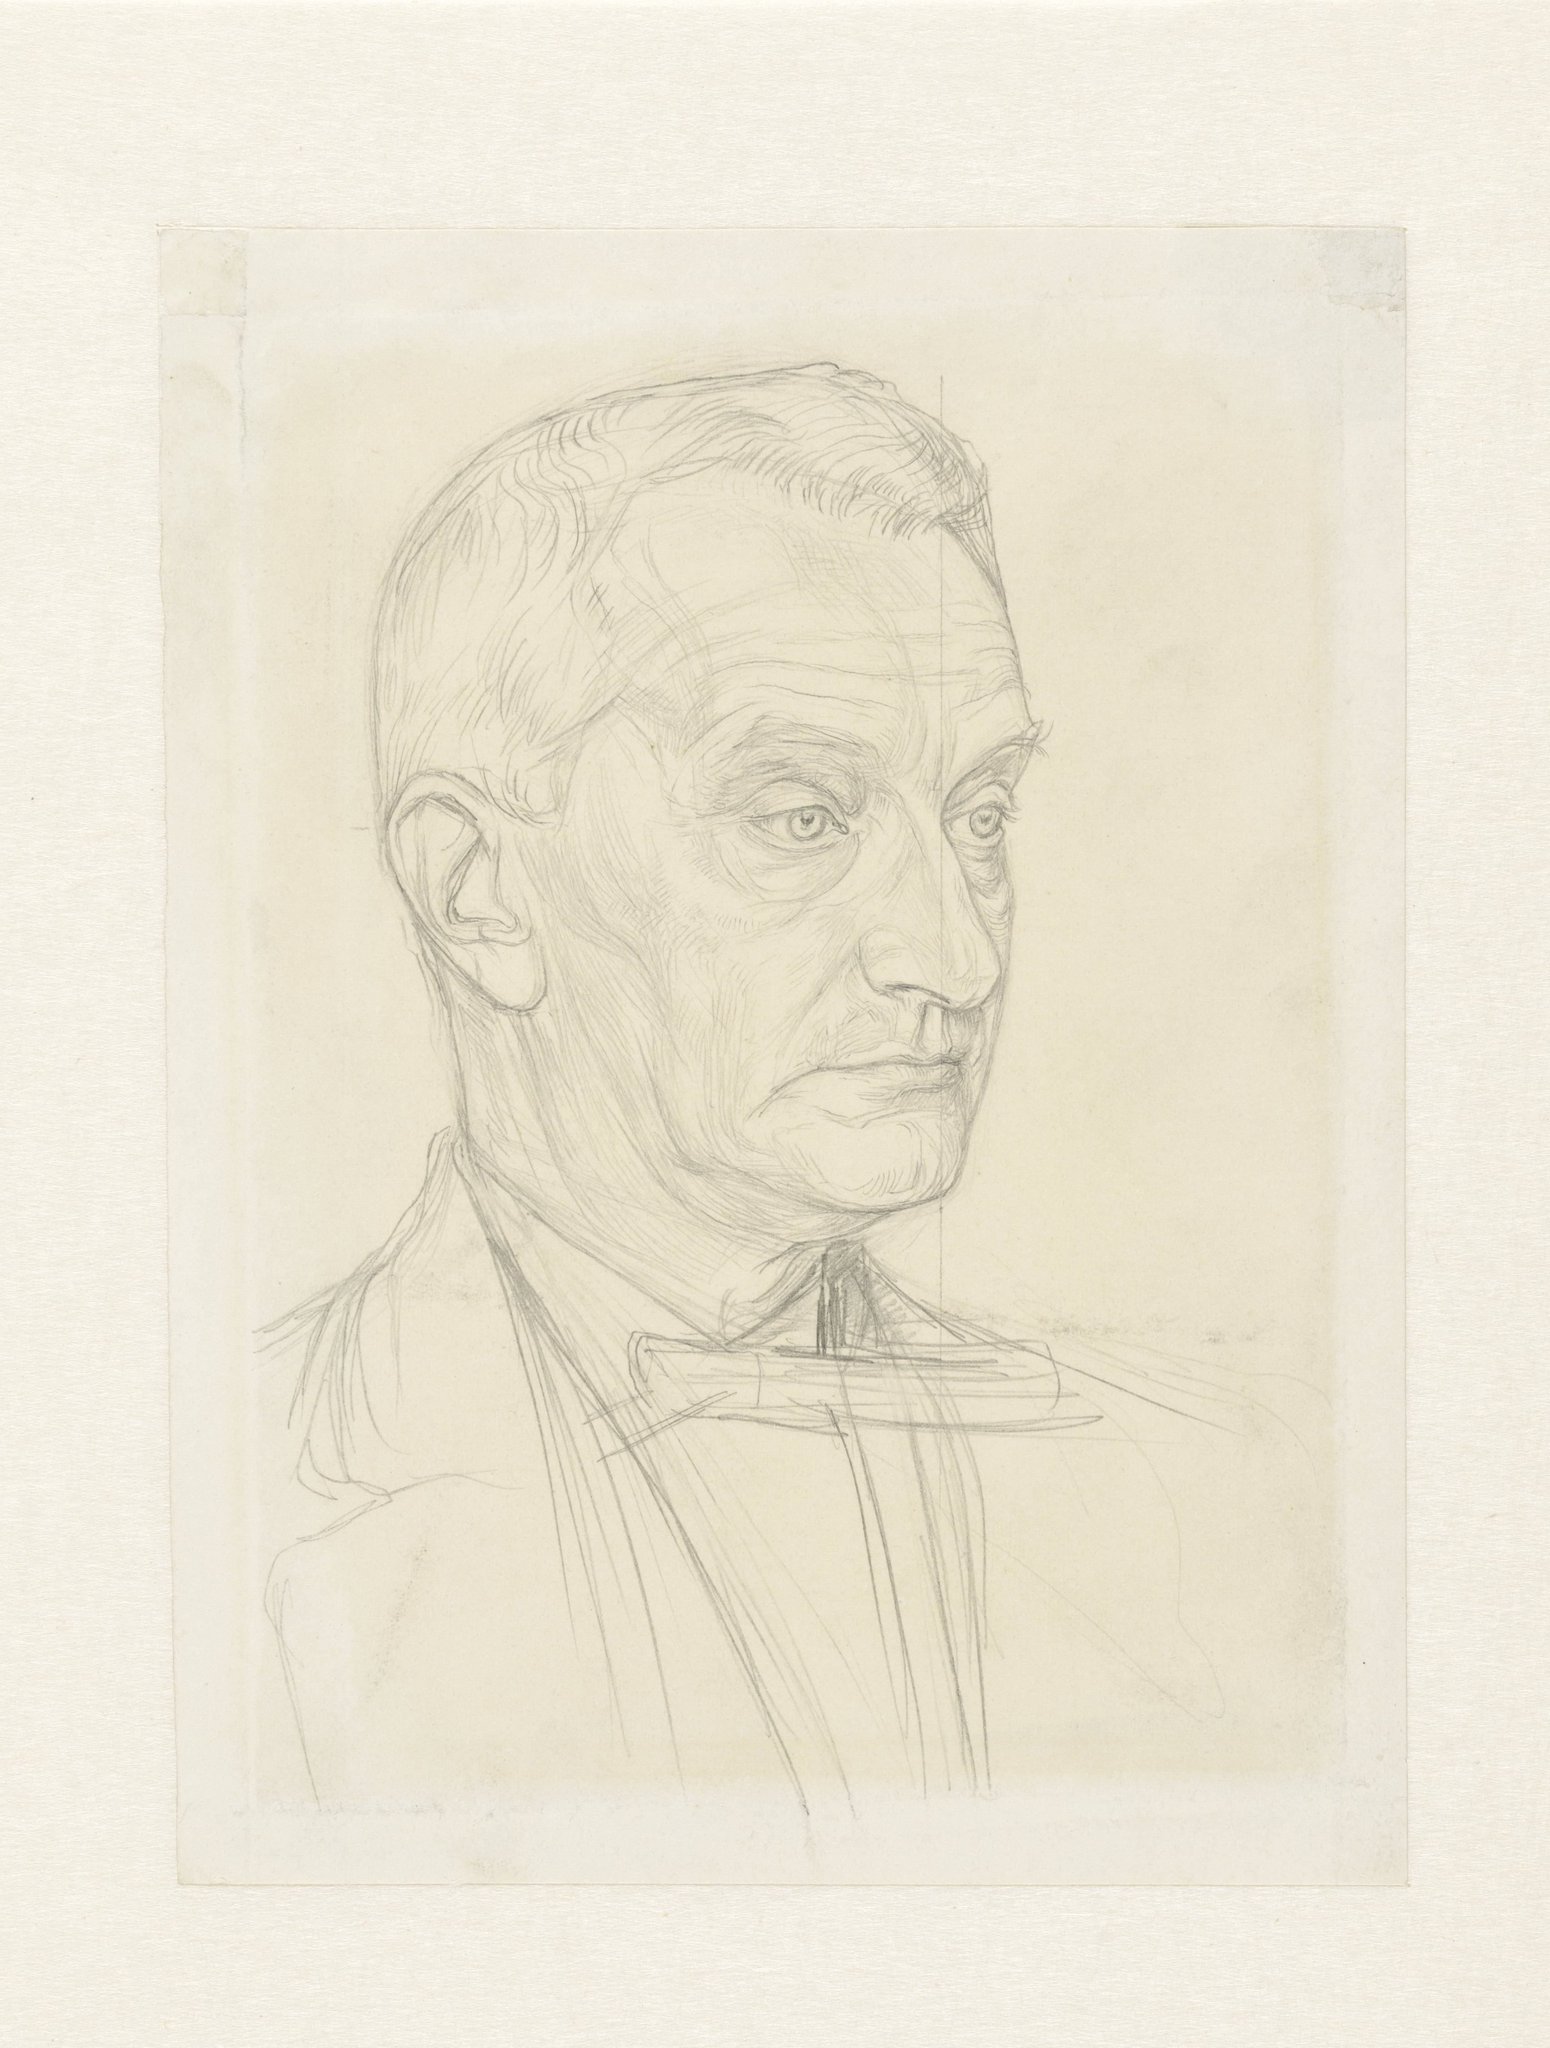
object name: drawing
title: Portret van Jan Egers van Iterson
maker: jan veth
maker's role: designer, draughtsman, painter, print maker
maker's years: 1864-1925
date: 1874-1925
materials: paper, pencil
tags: leiden, historical persons